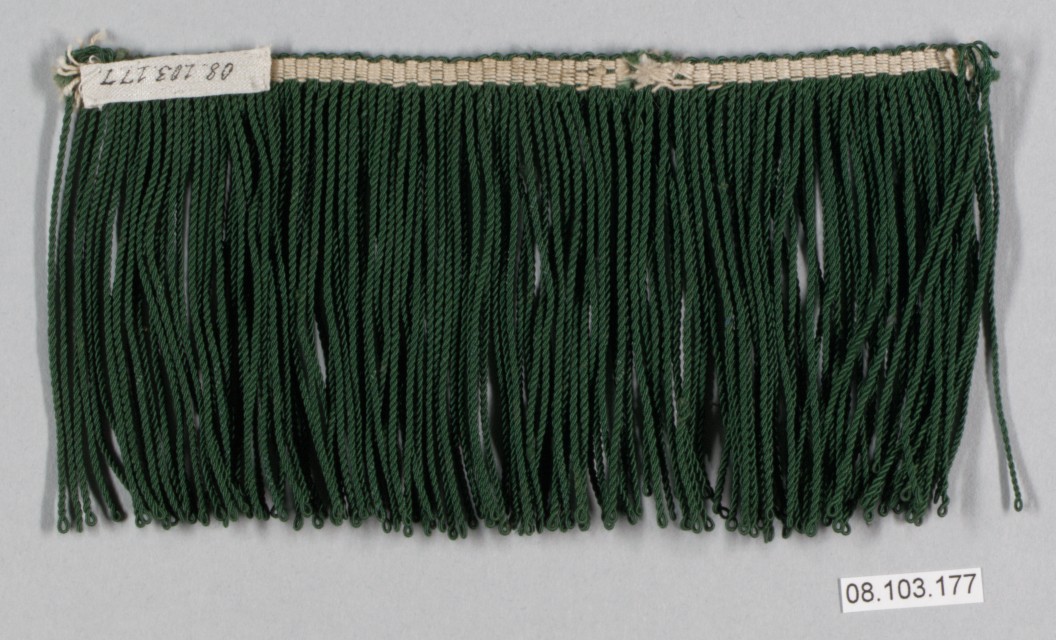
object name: fringe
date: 1801-1900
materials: cotton